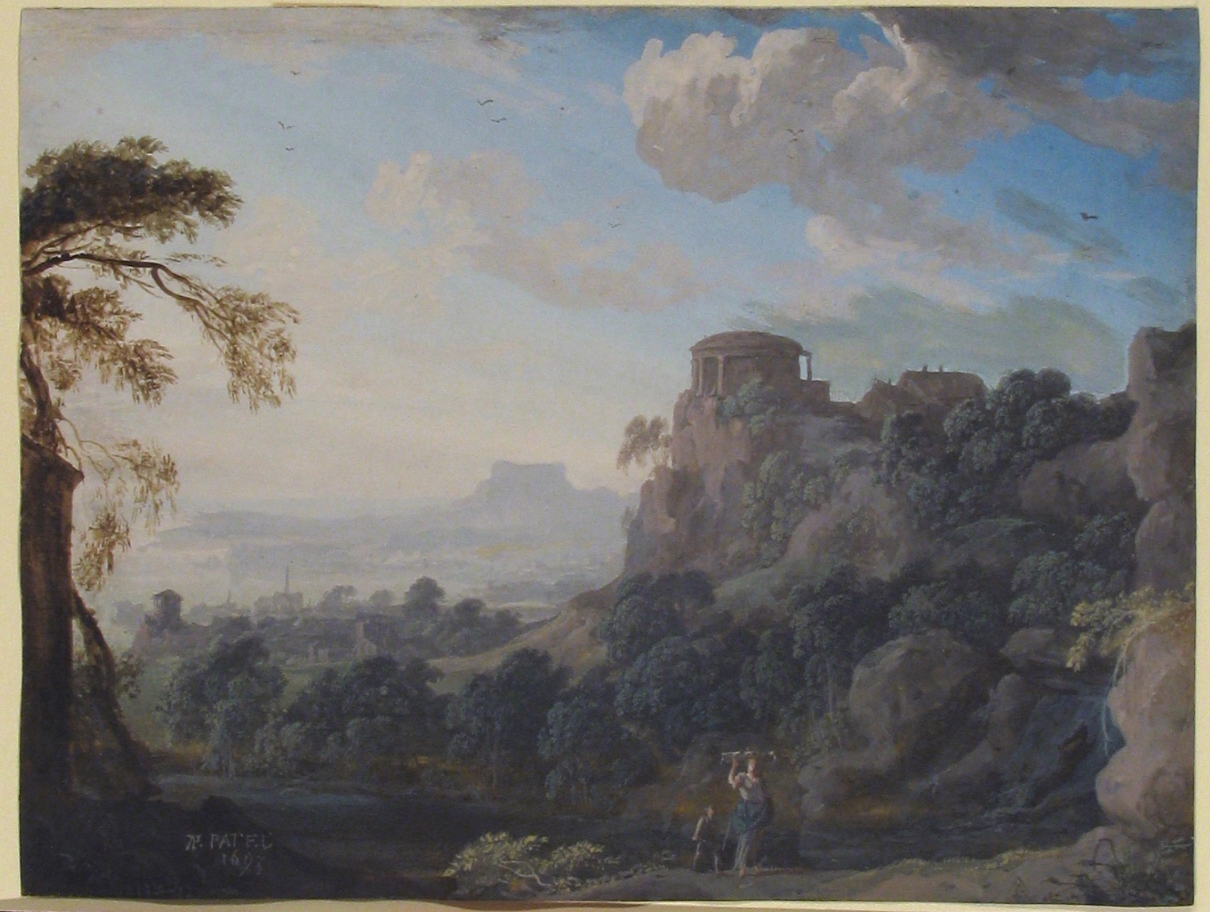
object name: drawing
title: Landscape with Figures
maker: pierre antoine patel the younger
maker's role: artist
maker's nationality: french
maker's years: 1646-1707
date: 1693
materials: gouache, parchment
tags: landscapes